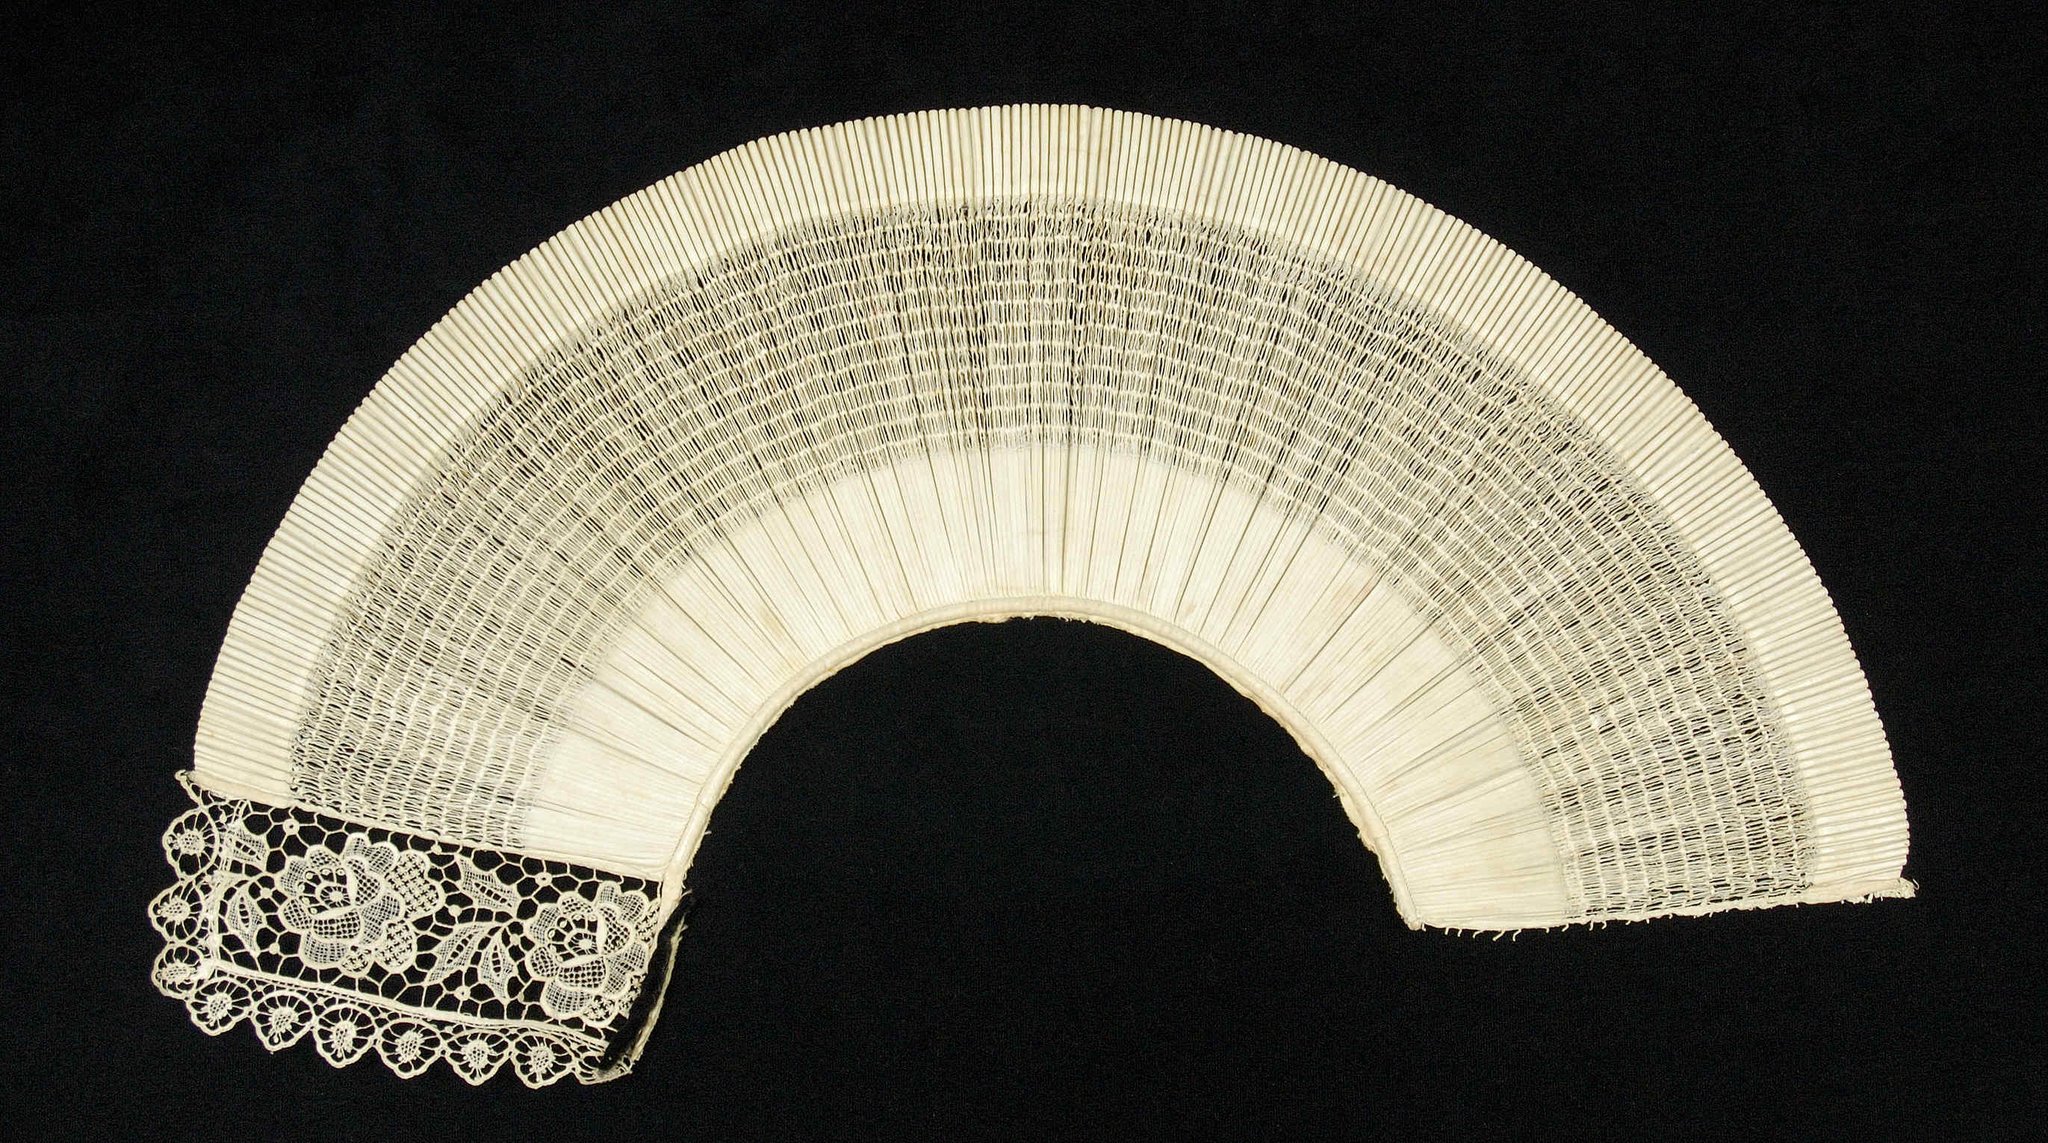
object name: collar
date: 1876-1900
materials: cotton